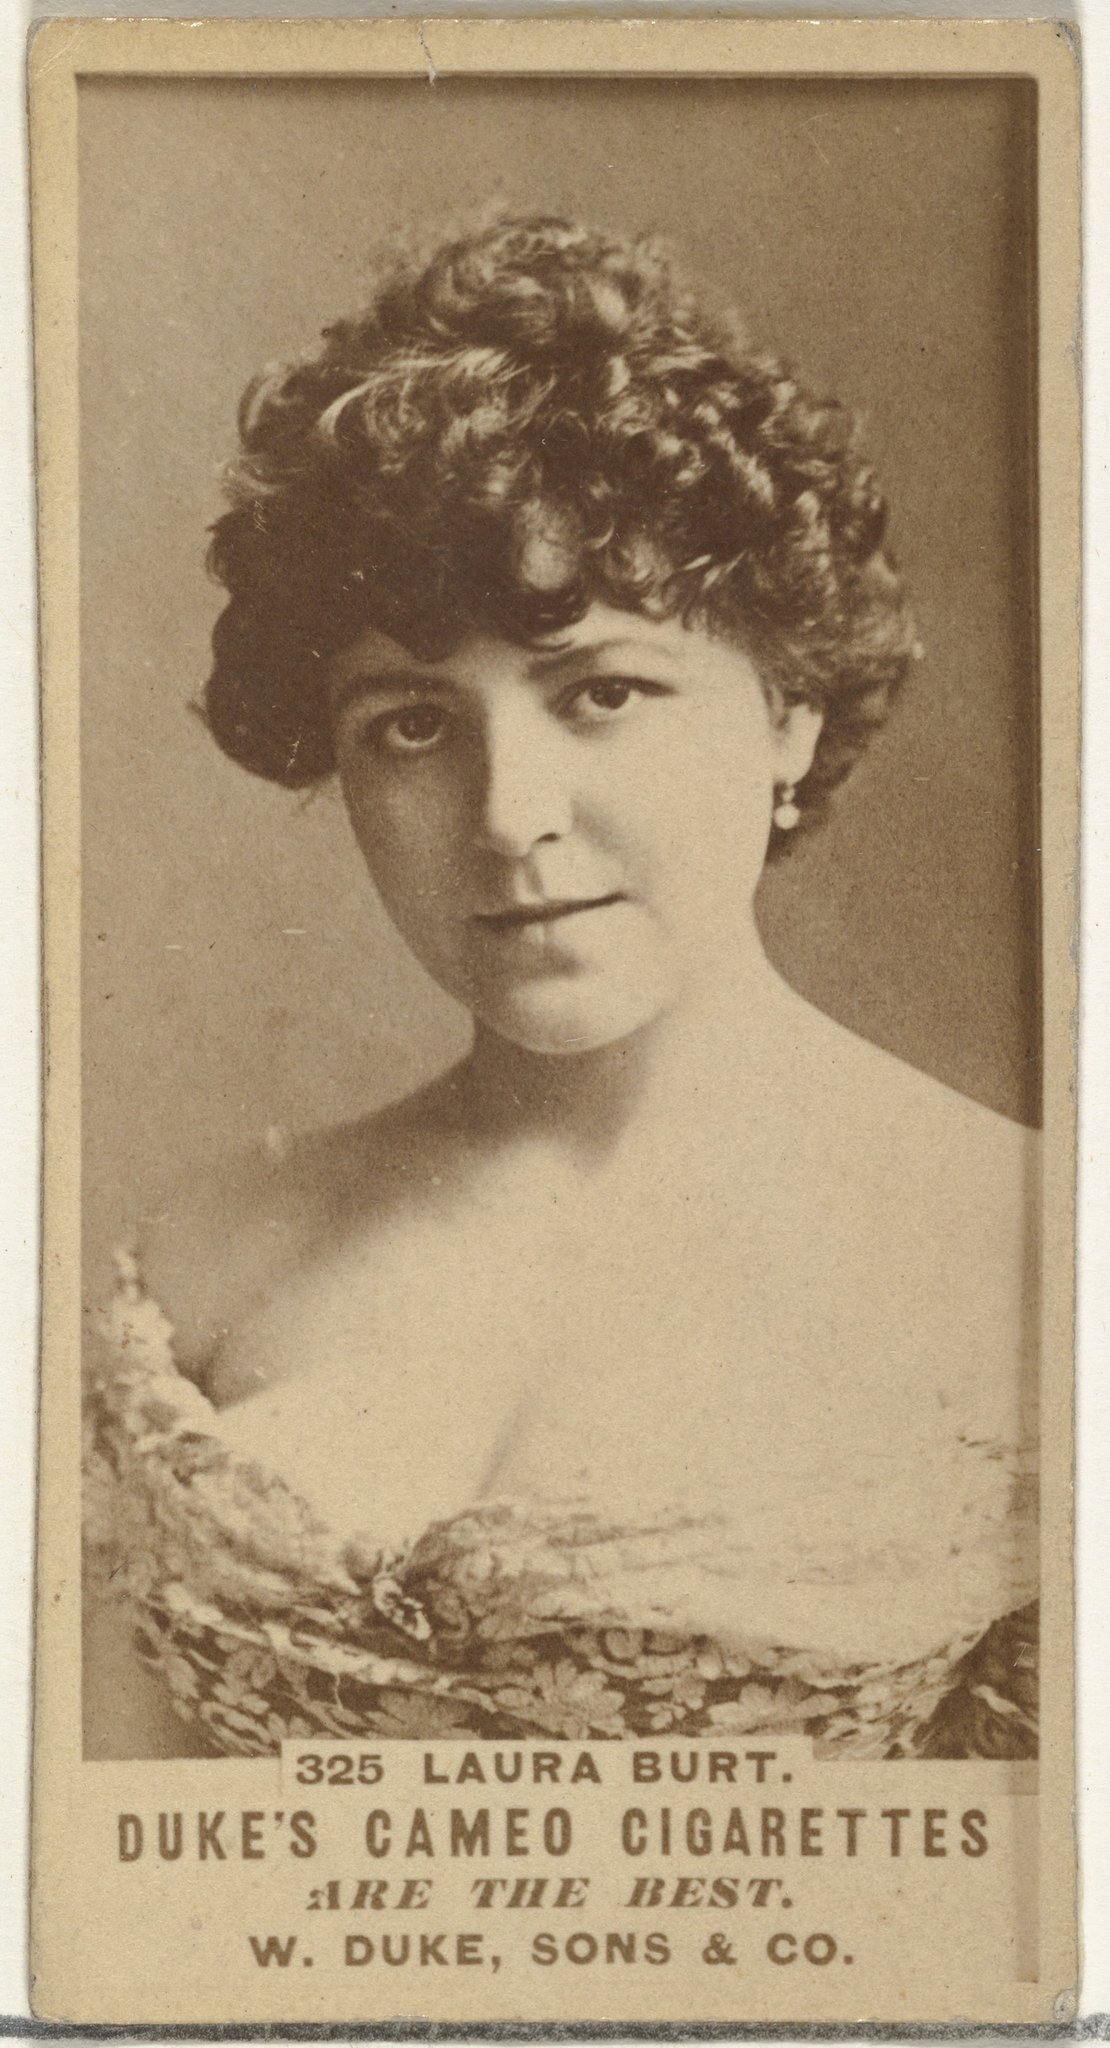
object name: photograph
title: Card Number 325, Laura Burt, from the Actors and Actresses series (N145-5) issued by Duke Sons & Co. to promote Cameo Cigarettes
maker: w. duke, sons & co.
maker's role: publisher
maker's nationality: american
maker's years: 1870-1920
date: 1880-1889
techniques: albumen silver print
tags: portraits,women,actresses